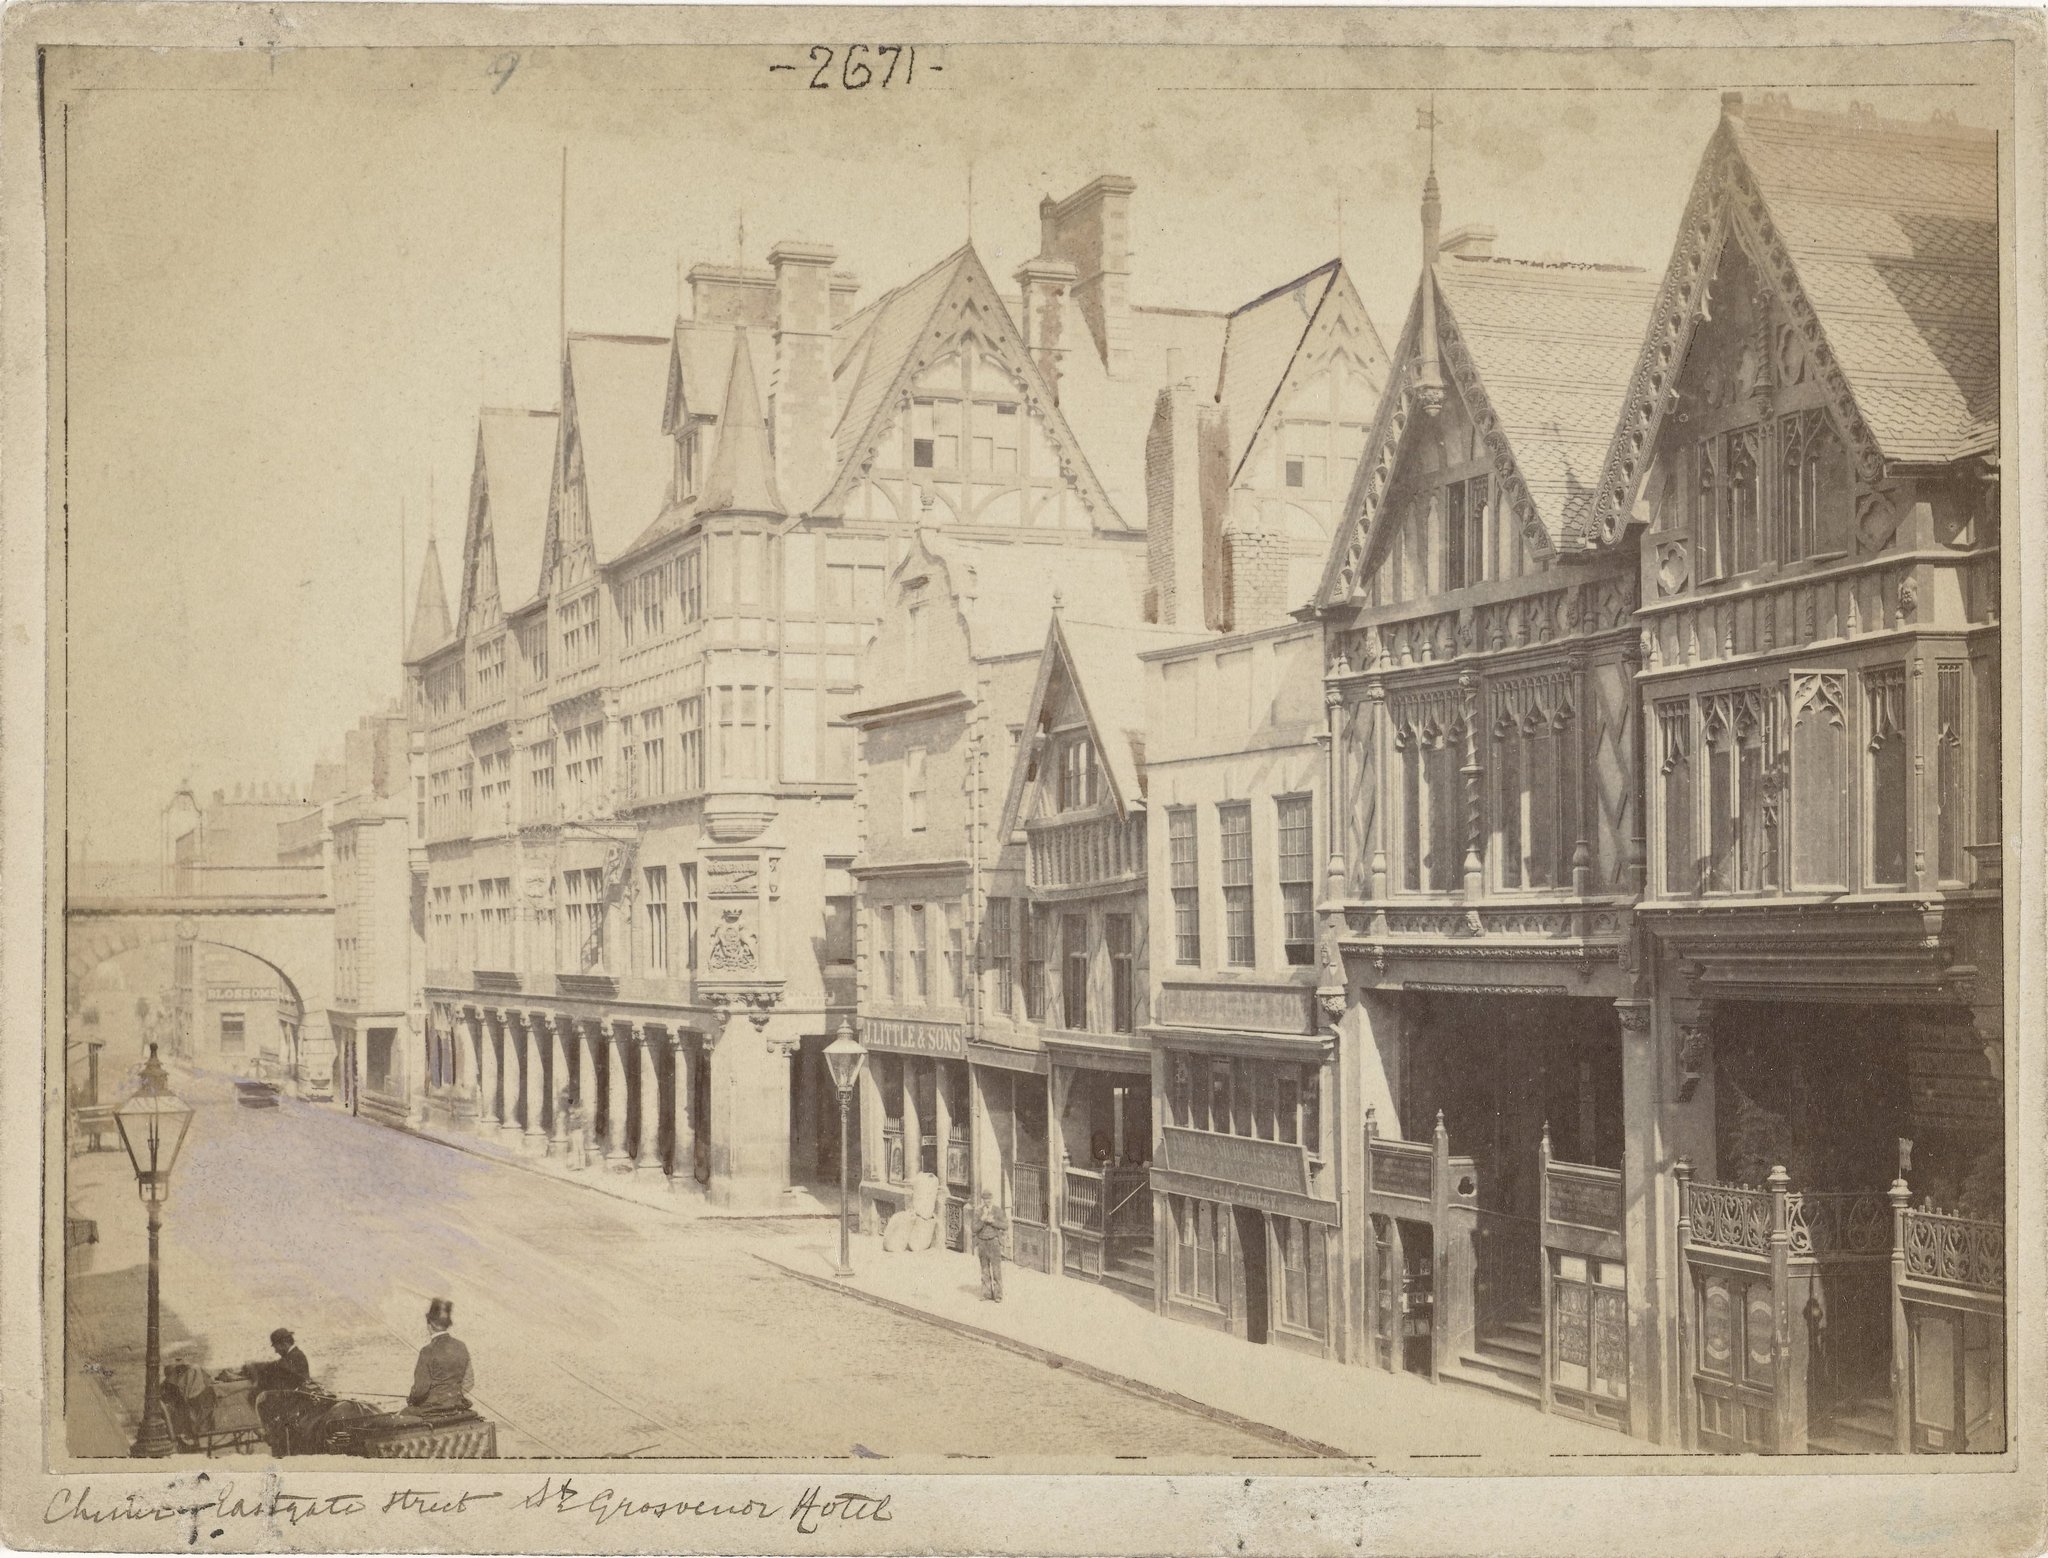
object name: photograph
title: Chester, Eastgate Street, St. Grosvenor Hotel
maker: Anonymous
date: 1866-1890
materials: paper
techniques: albumen print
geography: great britain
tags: hotel, hostelry, inn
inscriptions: number: ‘-2671-’